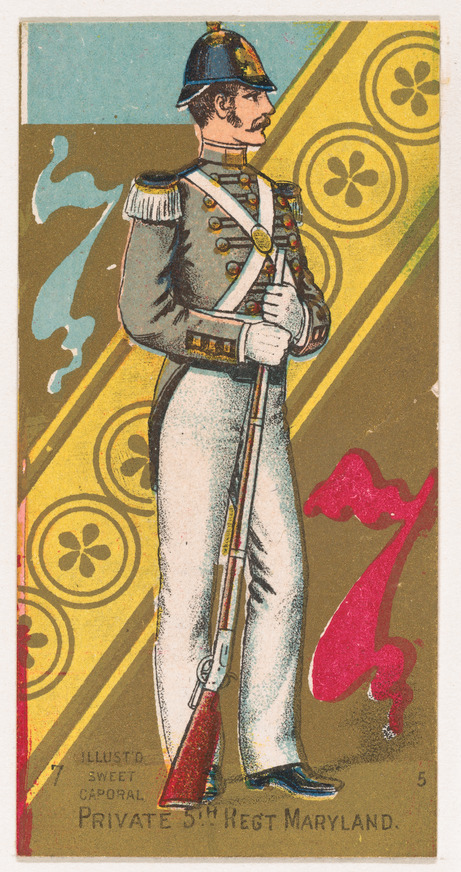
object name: print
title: Private, 5th Regiment, Maryland, from the Military Series (N224) issued by Kinney Tobacco Company to promote Sweet Caporal Cigarettes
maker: kinney brothers tobacco company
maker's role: publisher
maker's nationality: american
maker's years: 1869-2011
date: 1888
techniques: color lithograph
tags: soldiers,men,profiles